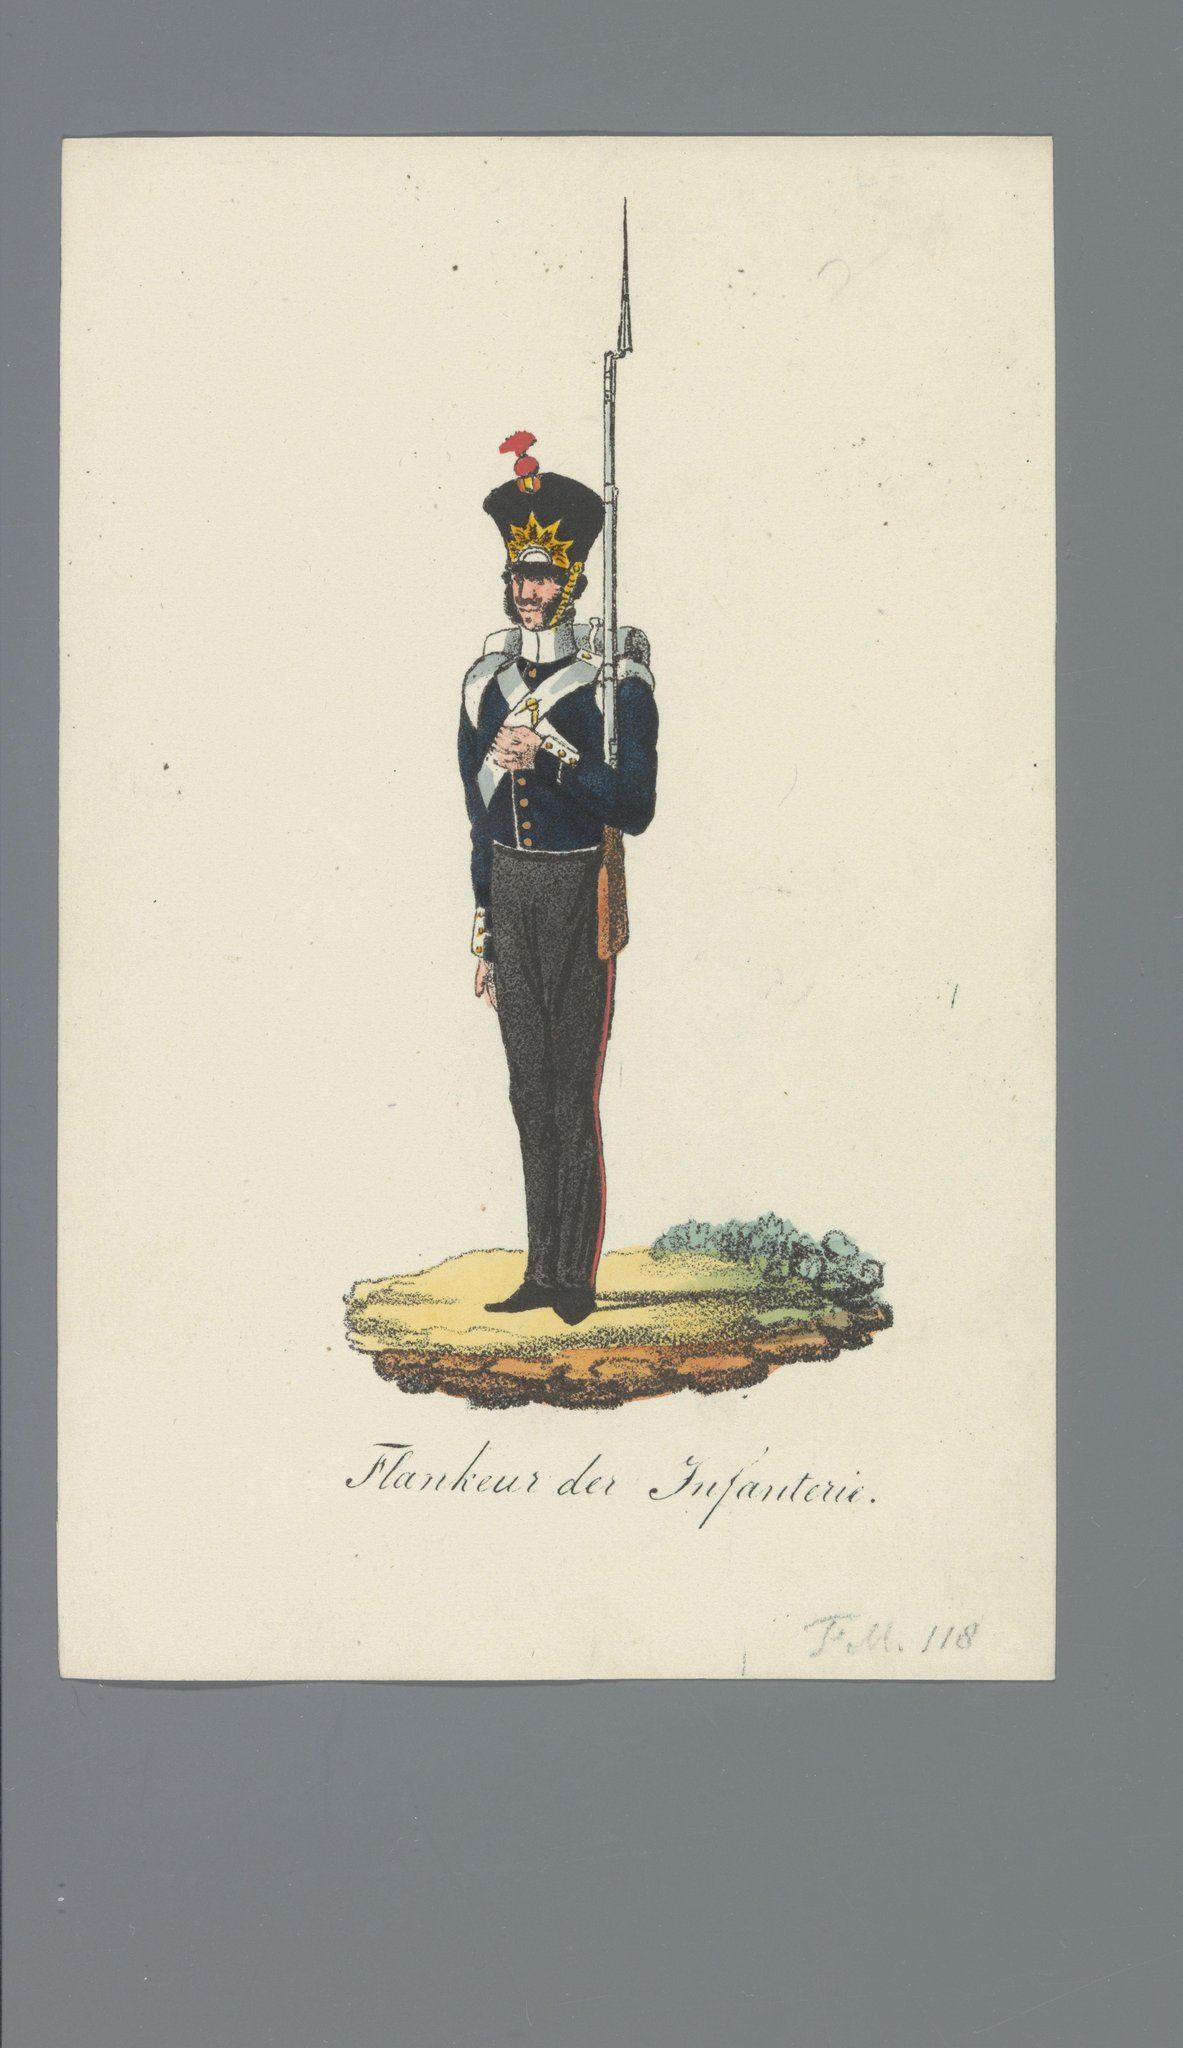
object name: print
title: Flankeur der Infanterie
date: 1835-1850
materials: paper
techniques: hand coloring, lithograph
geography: utrecht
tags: (military) uniforms, clothes, costume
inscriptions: collector's mark: Lugt 2228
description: Een flankeur van de infanterie, te voet. Onderdeel van een serie van 157 losse bladen met Nederlandse militaire uniformen in de jaren 1830-1832.